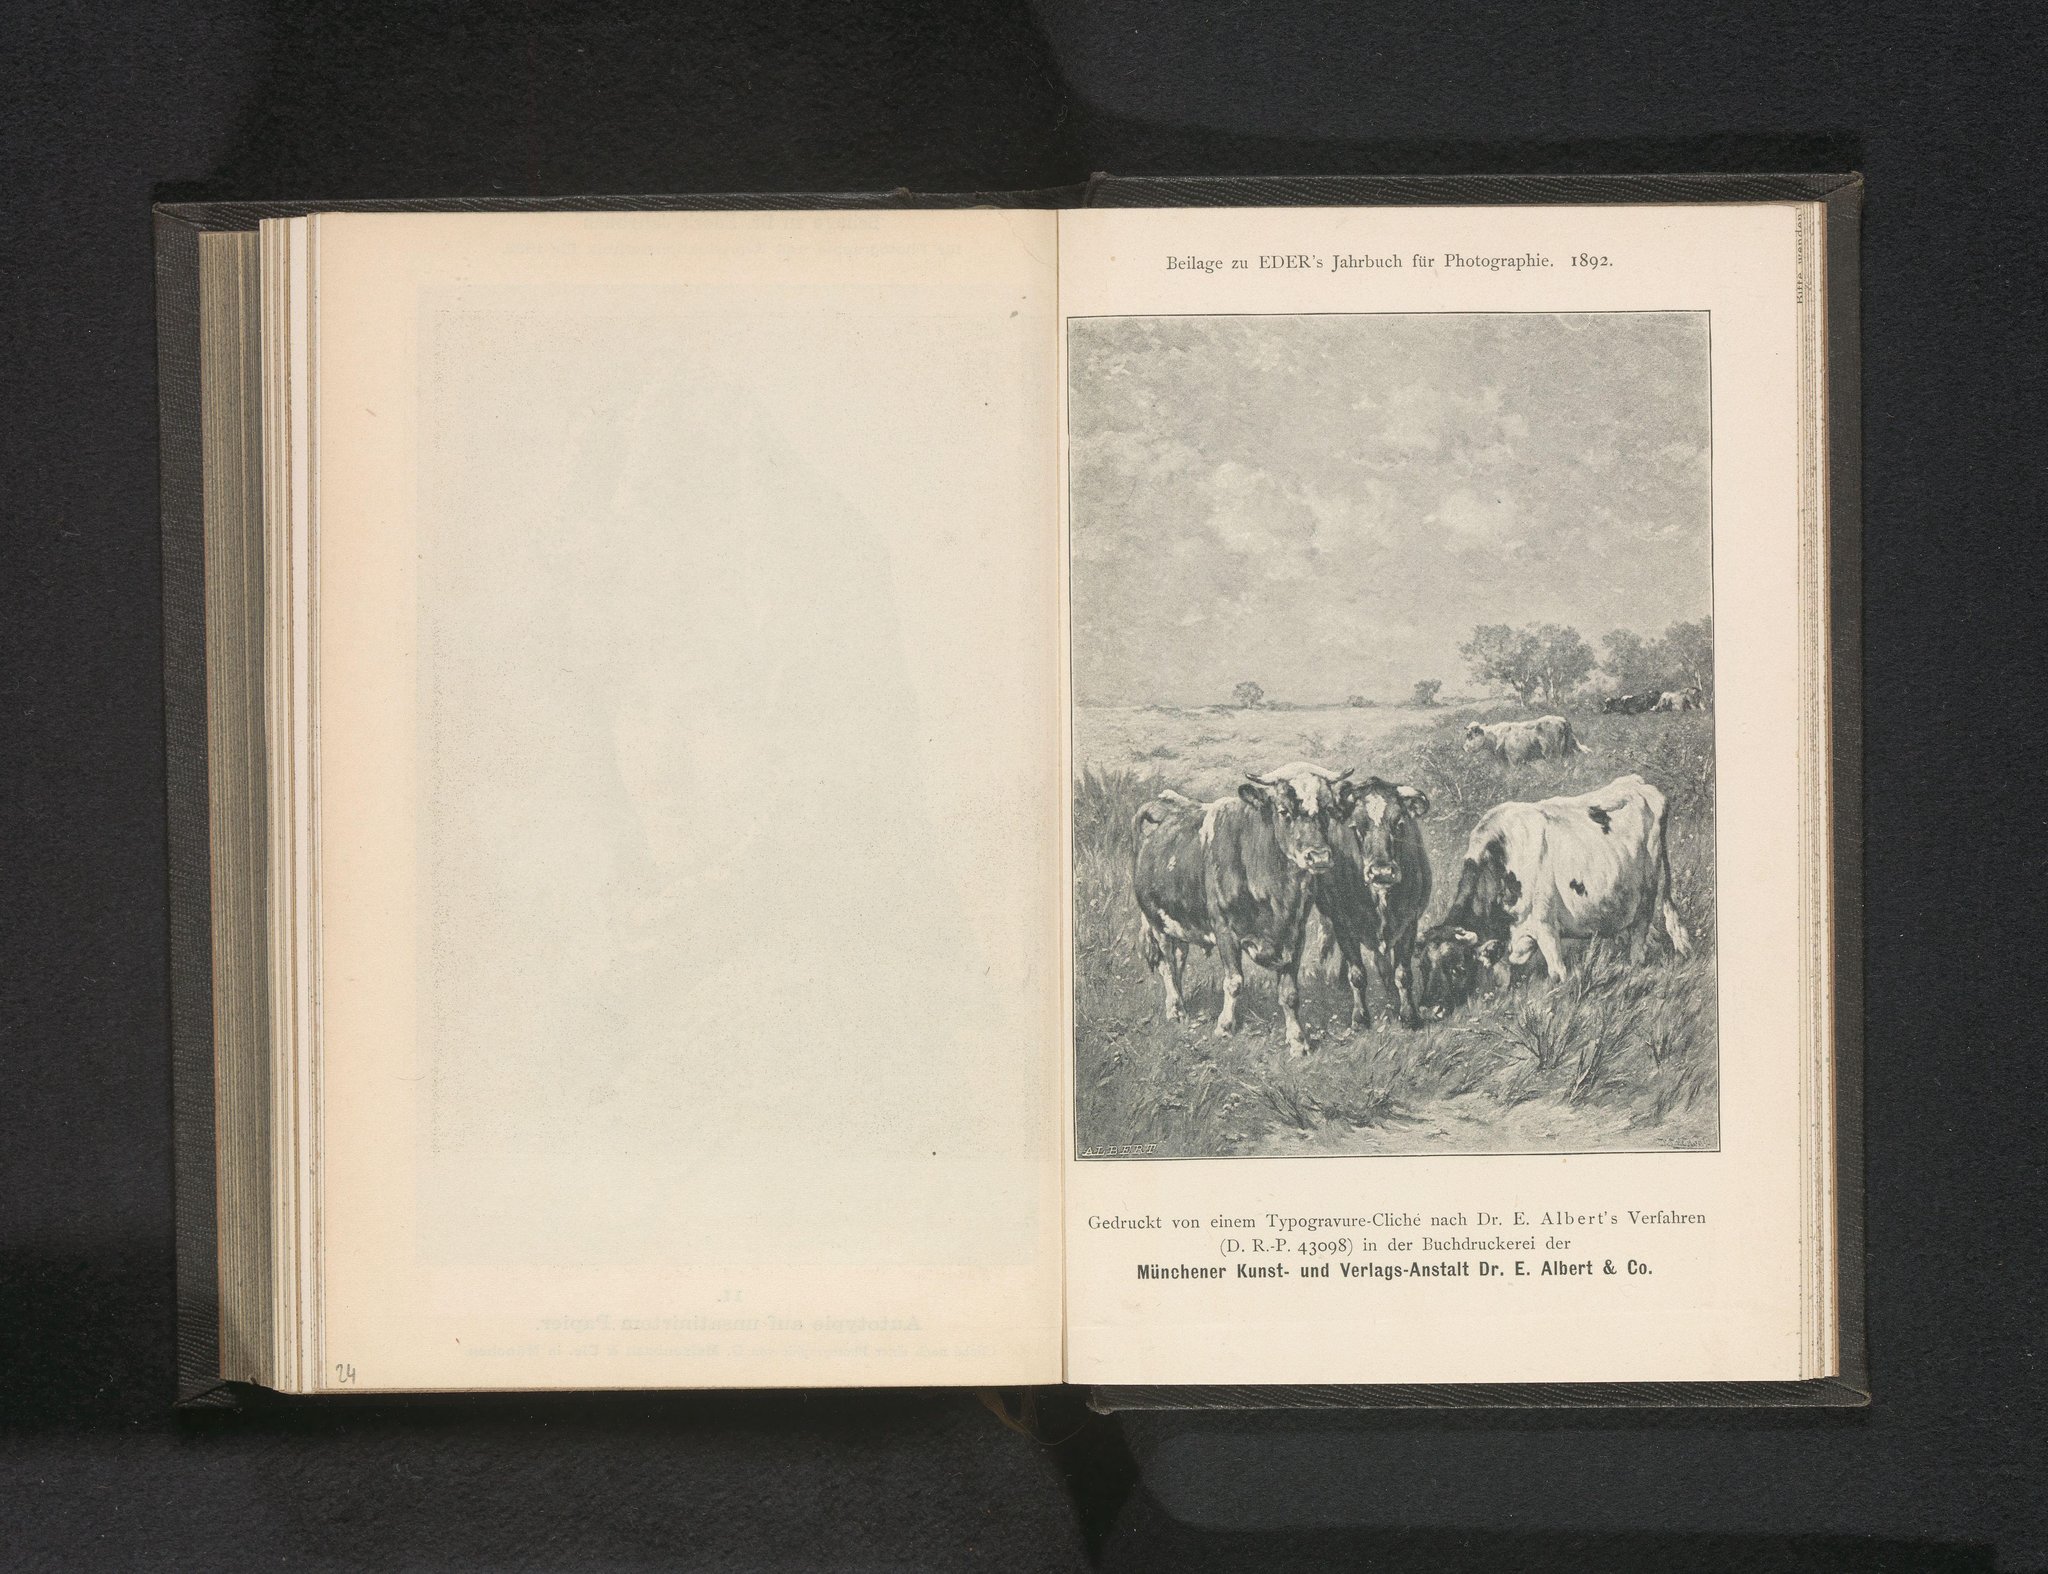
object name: page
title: Reproductie van een ontwerp van koeien in de wei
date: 1887-1892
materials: paper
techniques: autotype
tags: cow, meadow, pasture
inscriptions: inscription: ‘Beilage zu EDER's Jahrbuch für Photographie. 1892.’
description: Prent op negenenveertigste ongenummerde pagina na pagina 520.